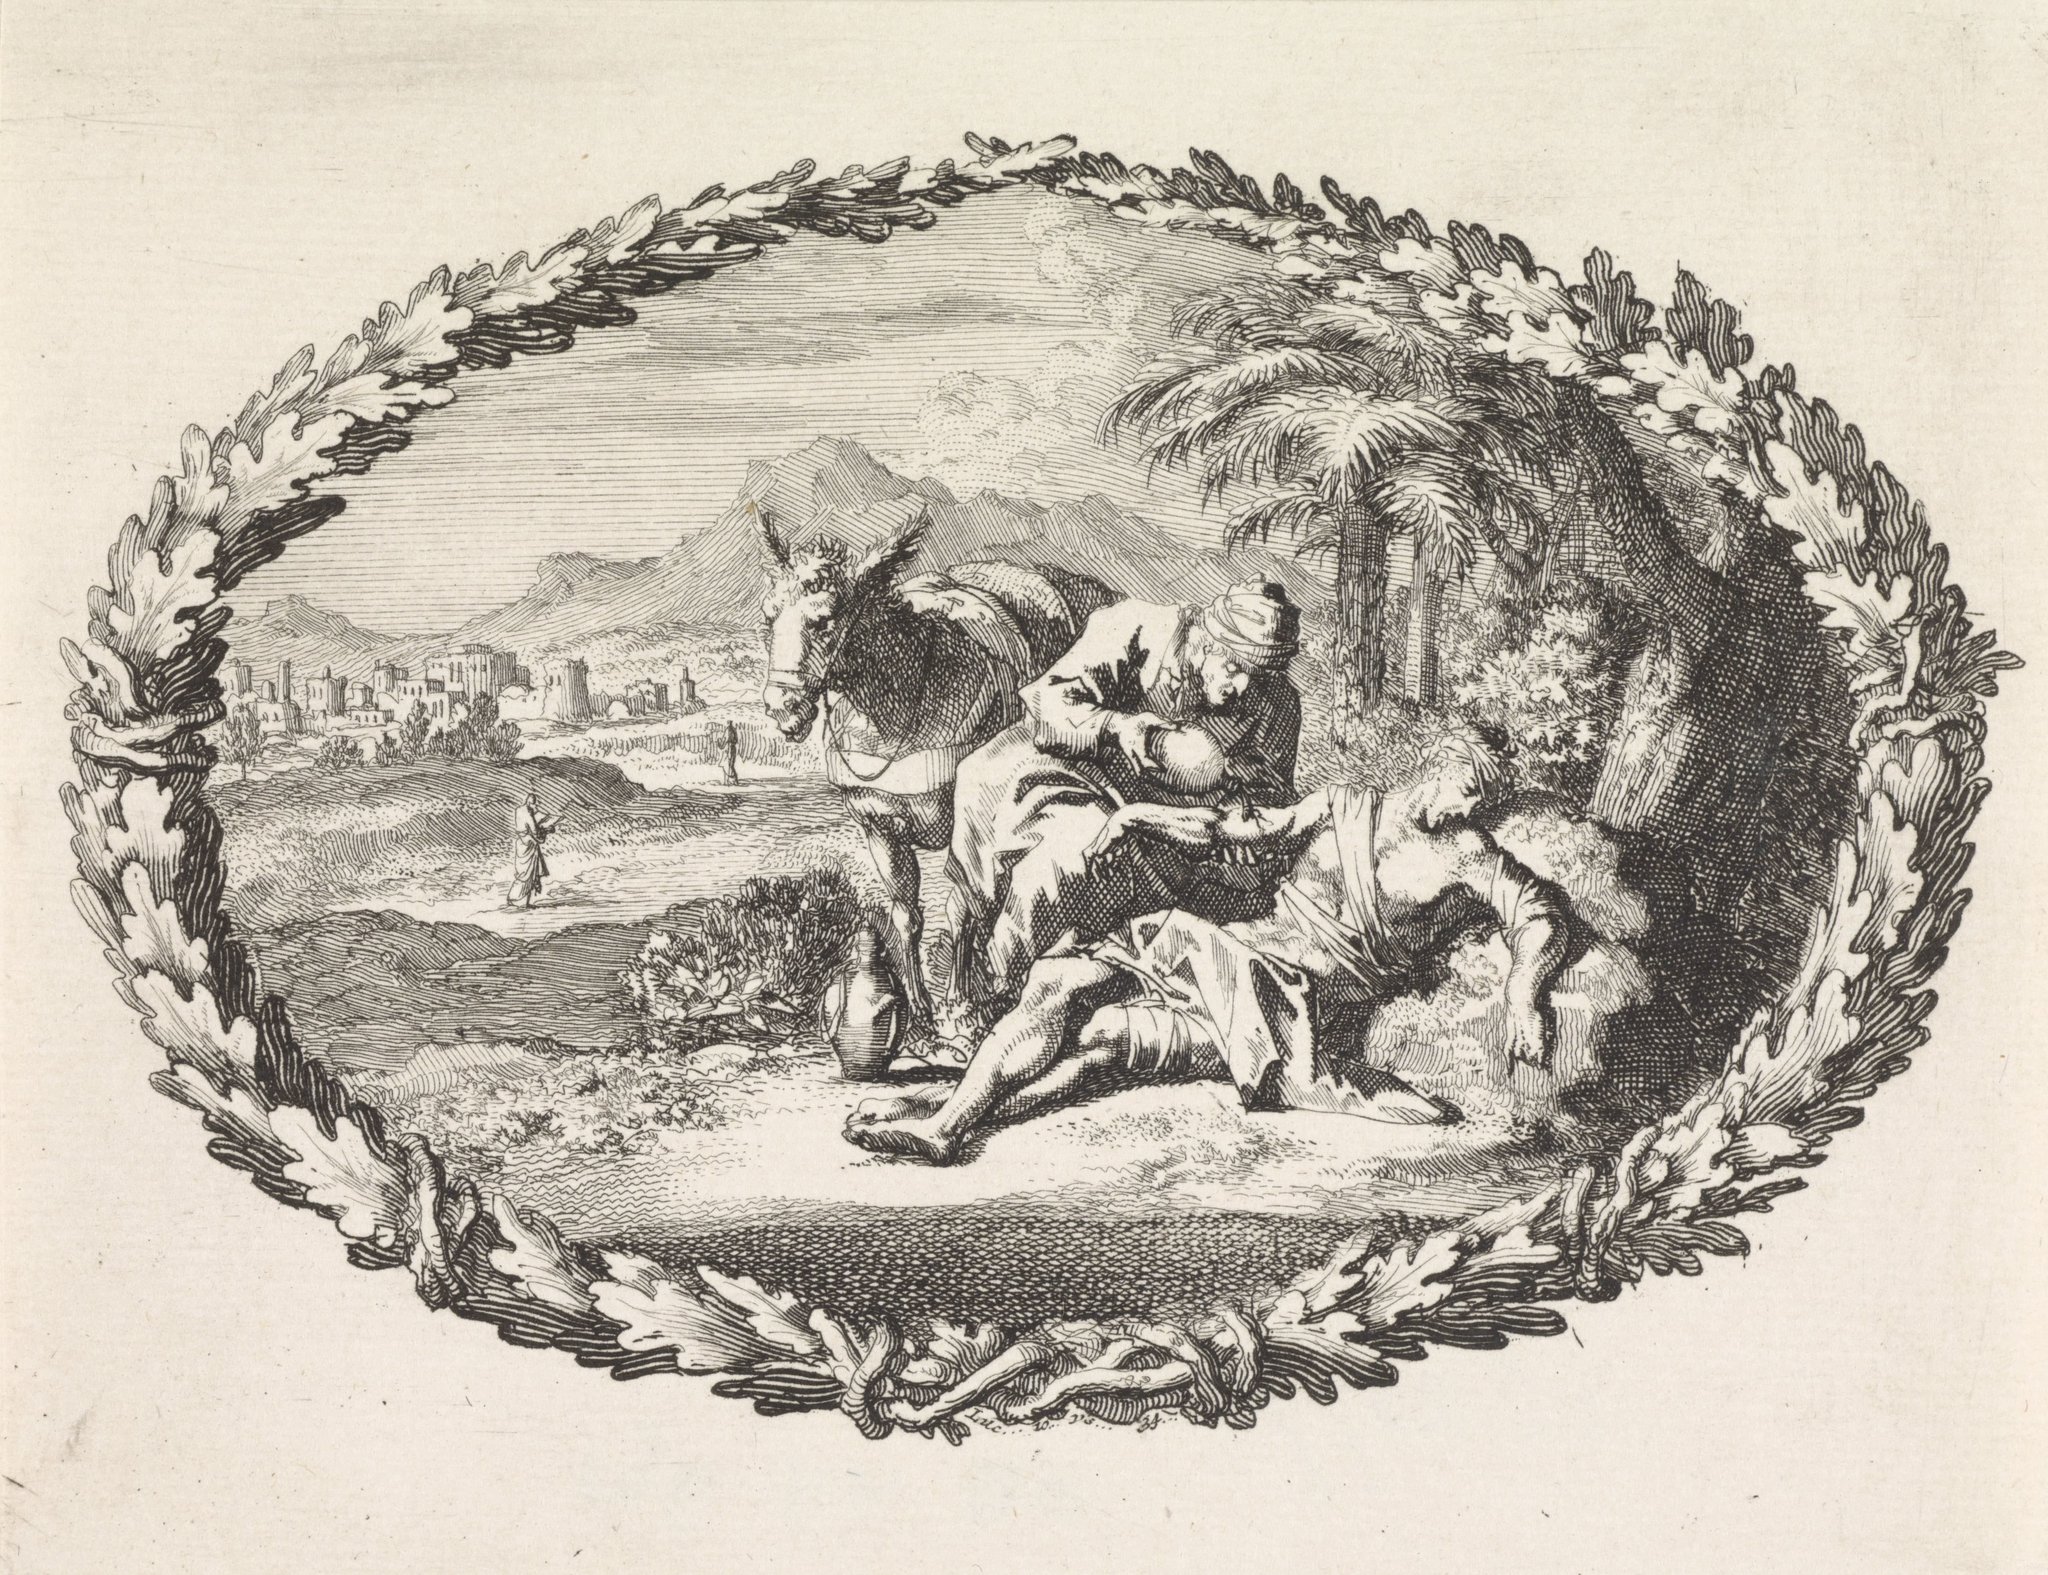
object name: print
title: Barmhartige Samaritaan verzorgt de wonden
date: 1700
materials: paper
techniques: etching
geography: amsterdam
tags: a priest and/or a levite passing by without attending to the wounded man ~ parable of the good samaritan, a samaritan tending the wounds of the traveller, ornament ~ cartouche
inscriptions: collector's mark: Lugt 2228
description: Een voorstelling in een cartouche van palmtakken. De barmhartige Samaritaan ondersteunt de beroofde en gewonde man en giet olie en wijn over zijn verwondingen. Op de achtergrond de priester en de Leviet in een landschap. Onder de cartouche de Bijbelreferentie Luc. 10:35.